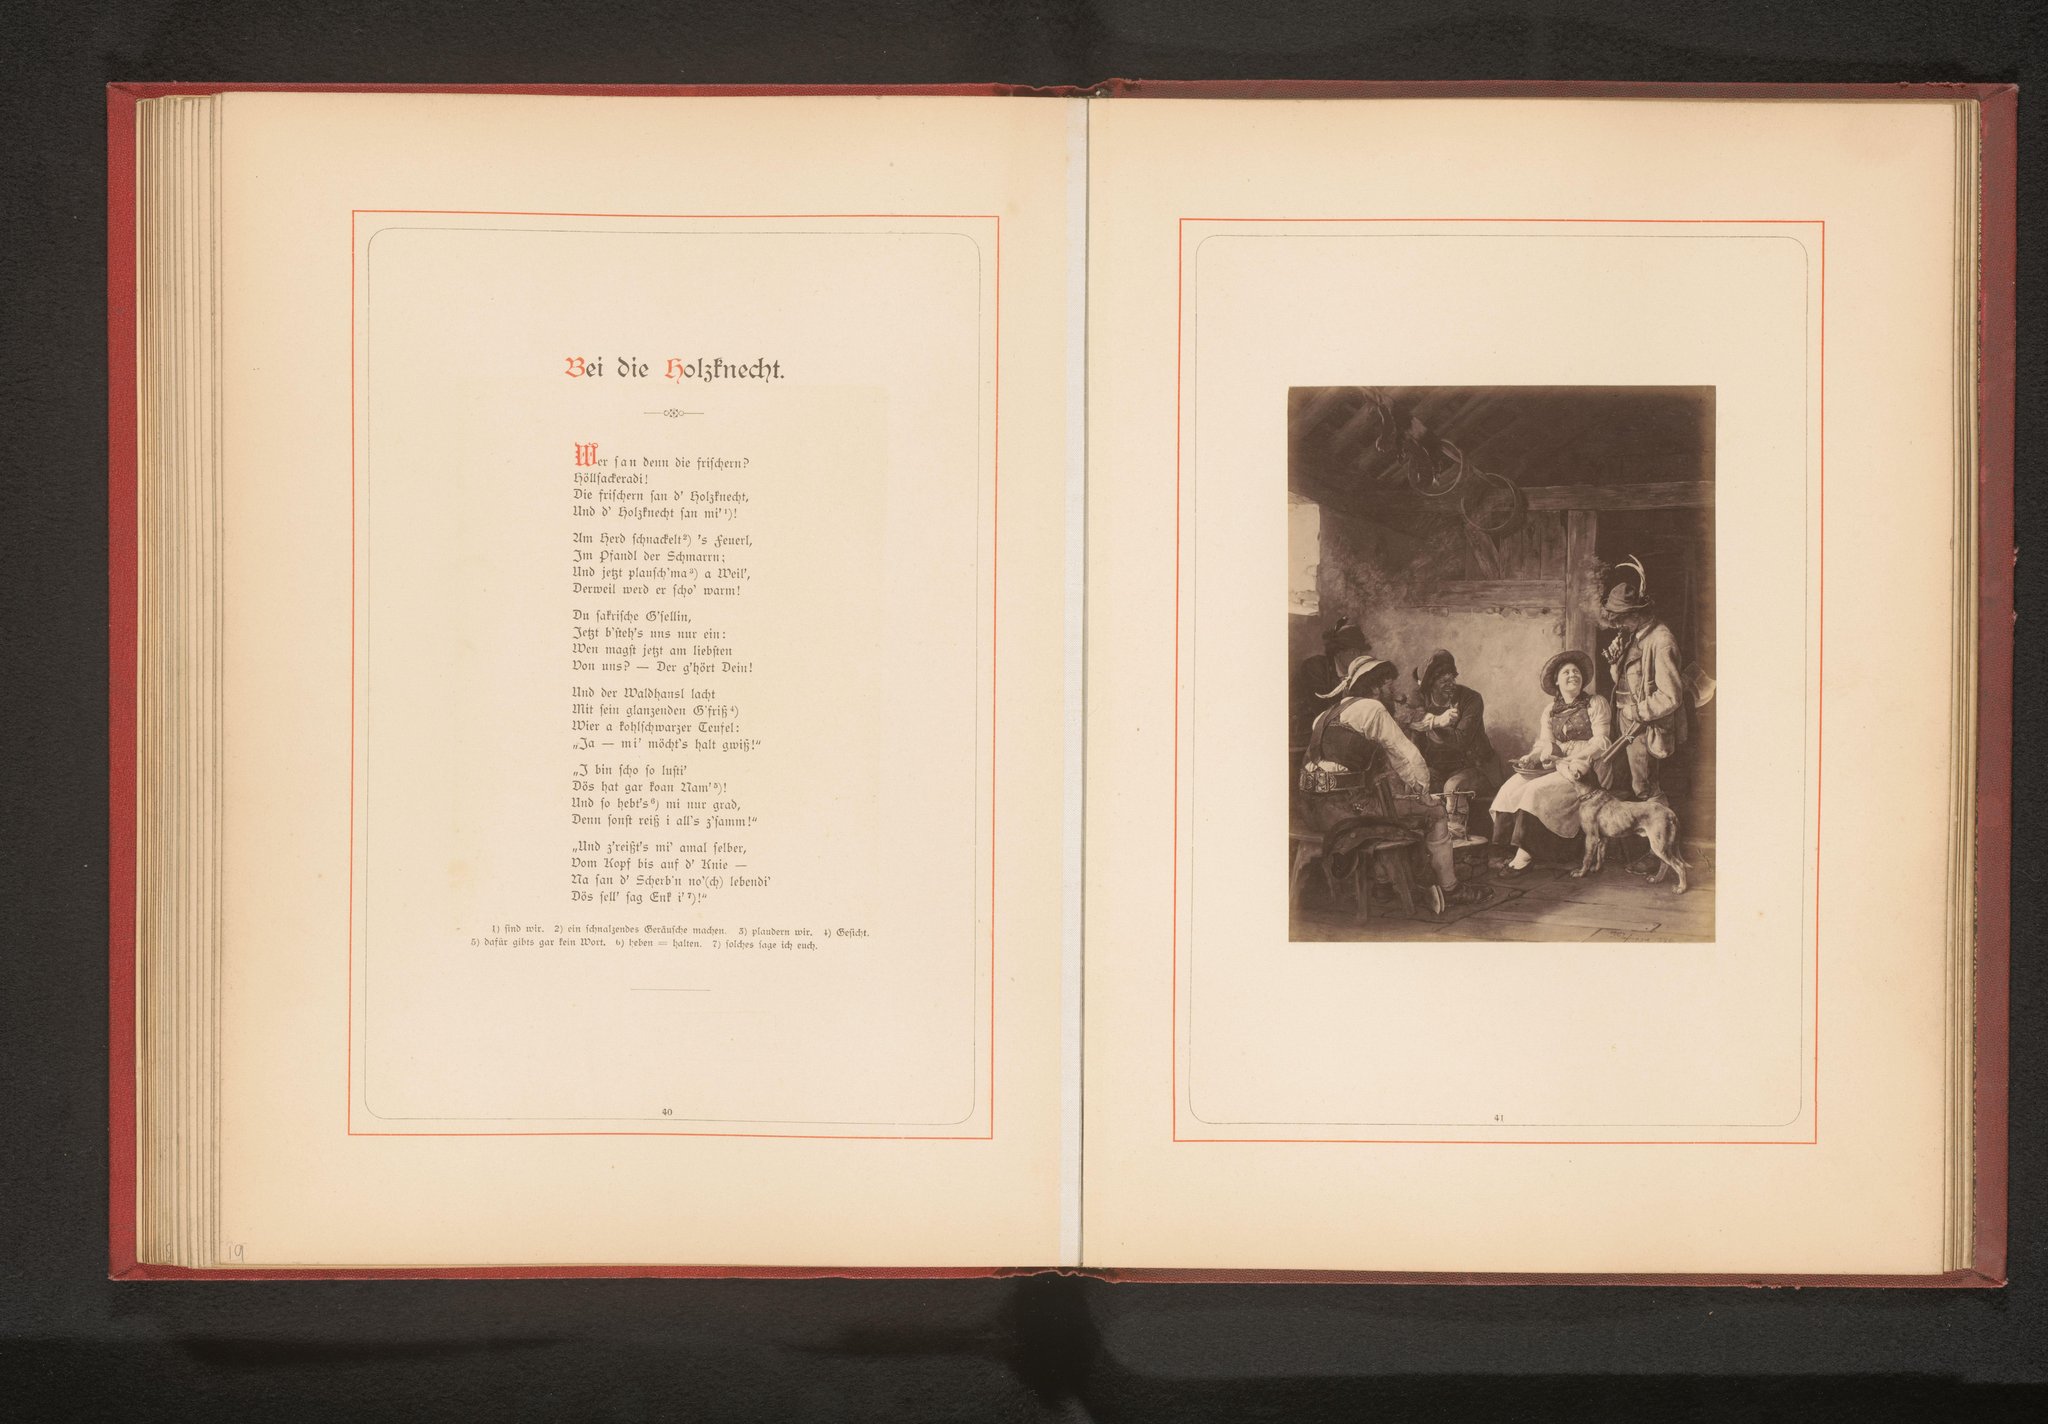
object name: page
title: Fotoreproductie van een schilderij, voorstellende een gezelschap rond een vuur in een interieur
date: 1880-1885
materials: photographic support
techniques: albumen print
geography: germany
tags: open fire (in general), interior ~ representation of a building, dog